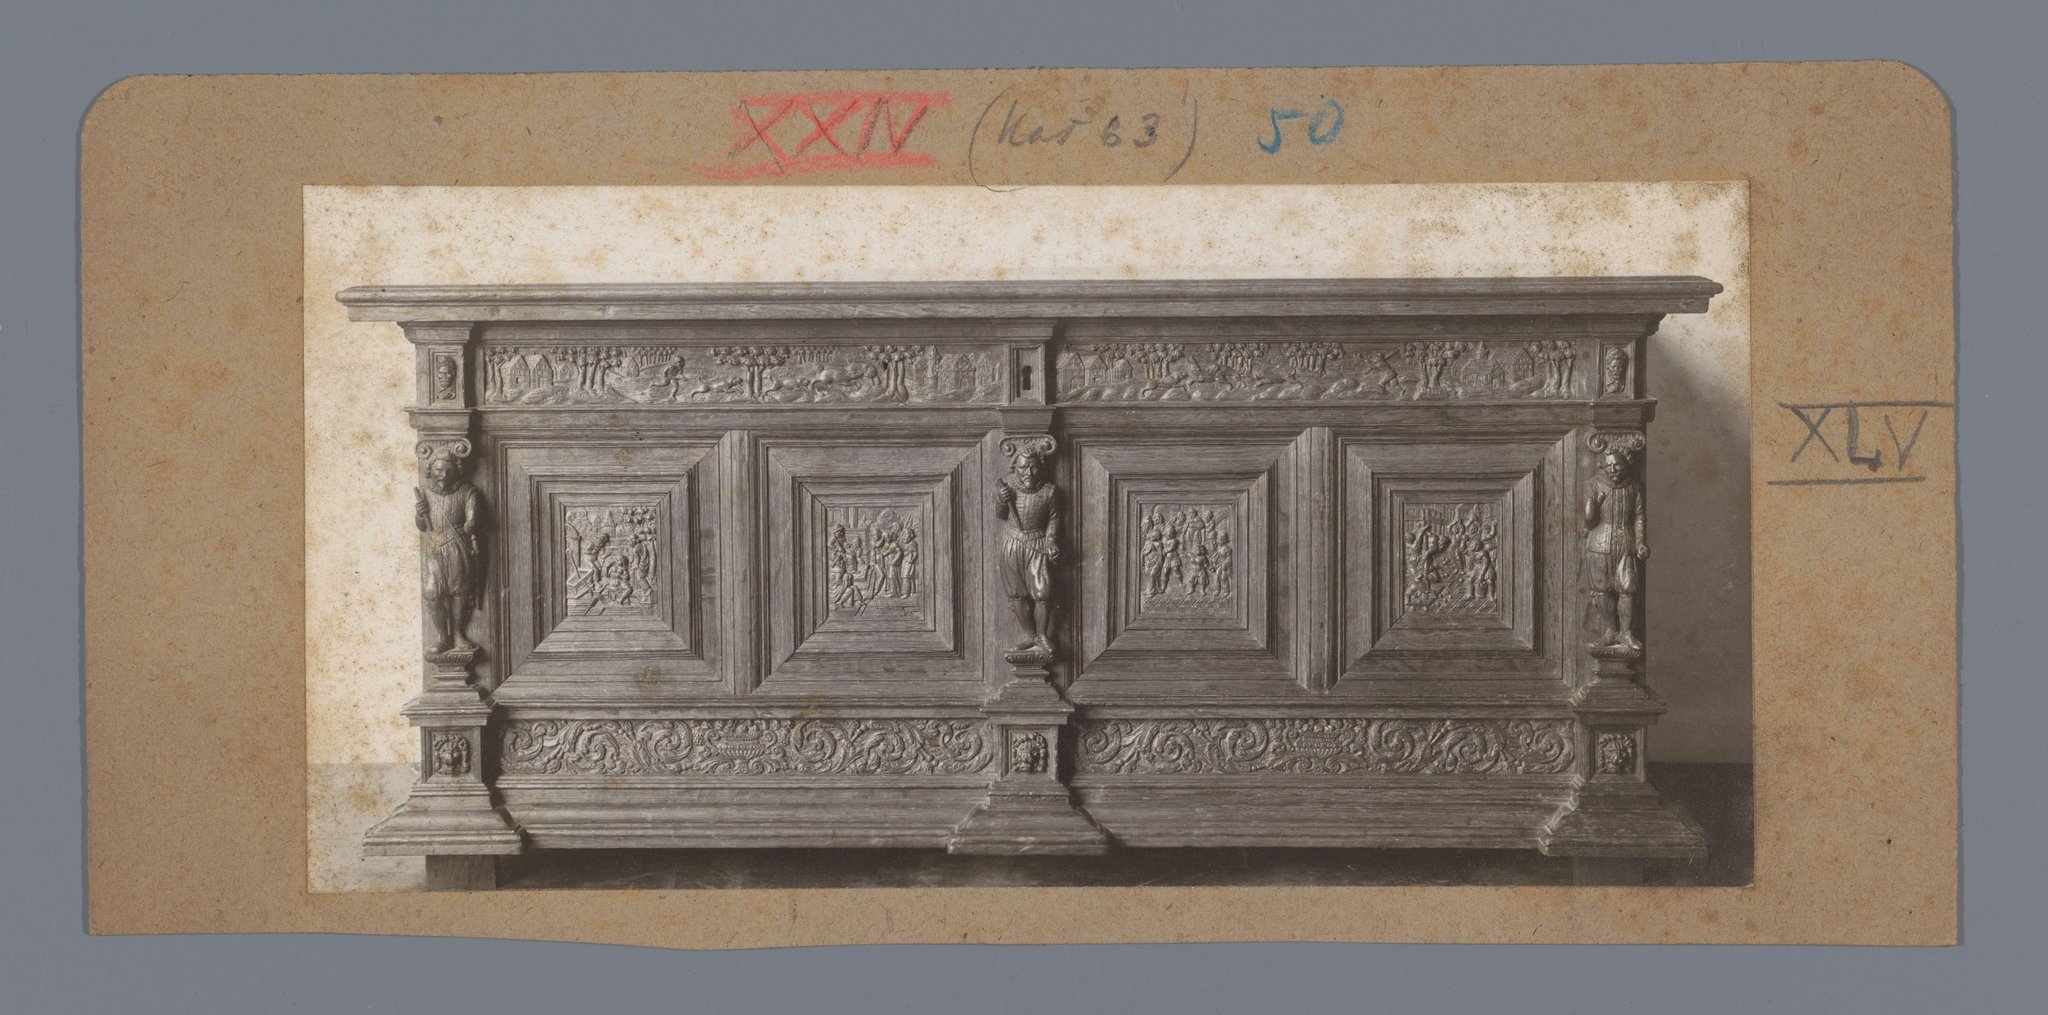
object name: photograph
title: Kist gedecoreerd met drie mannen en verhalende scenes (vermoedelijk) in het Rijksmuseum te Amsterdam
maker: Anonymous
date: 1875-1900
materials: photographic support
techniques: matte daylight collodion silver print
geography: amsterdam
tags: chest, coffer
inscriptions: collector's mark: ‘Instituut voor kunst-nijverheidsonderwijs Gabriël Metsustraat No. 16, Amsterdam’, number: ‘XXIV (Kat 63) 50 XLV’, collector's mark: ‘Kunstnijverheidschool Quellinus Amsterdam Frans Halsstraat 14.’